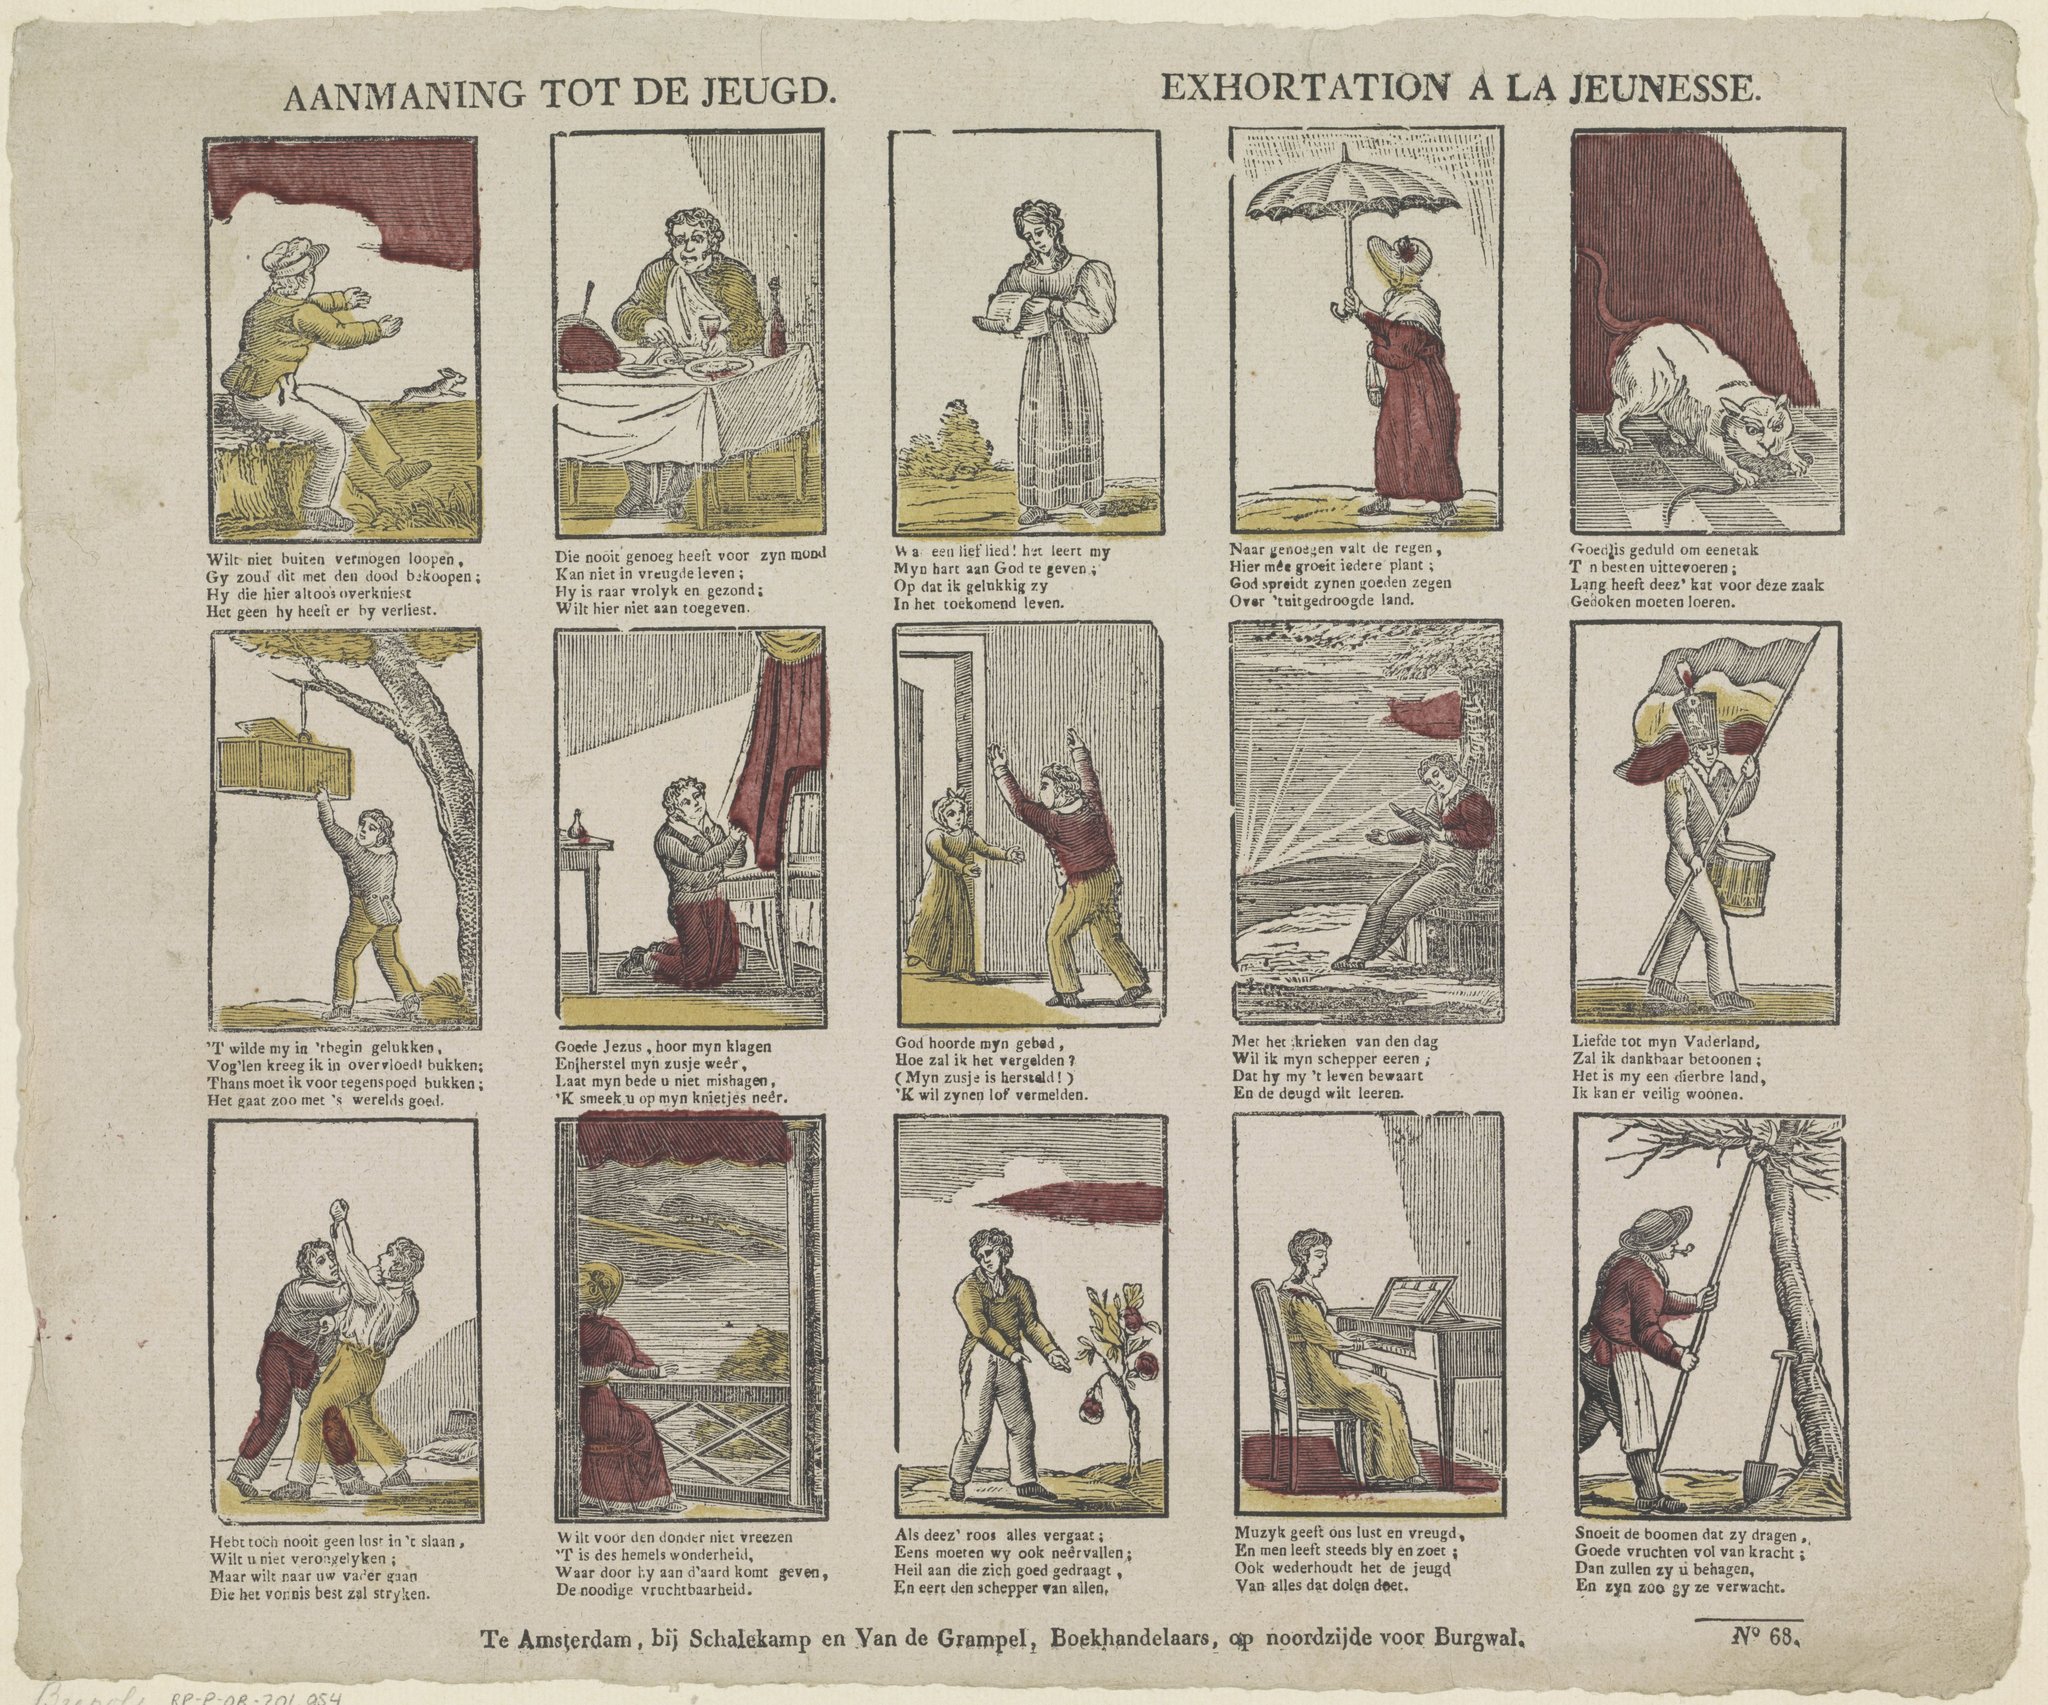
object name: popular print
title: Aanmaning tot de jeugd / Exhoration a la jeunesse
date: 1806-1837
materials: paper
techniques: colour, letterpress printing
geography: turnhout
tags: musician at work, characters (human types), cat and mouse, fist-fight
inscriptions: collector's mark: Lugt 2760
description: Blad met 15 voorstellingen van verschillende figuren en bezigheden, waaronder een vrouw met paraplu, een kat die een muis vangt en een vrouw die piano speelt. Onder elke voorstelling een vierregelig vers. Genummerd rechtsonder: No 68.